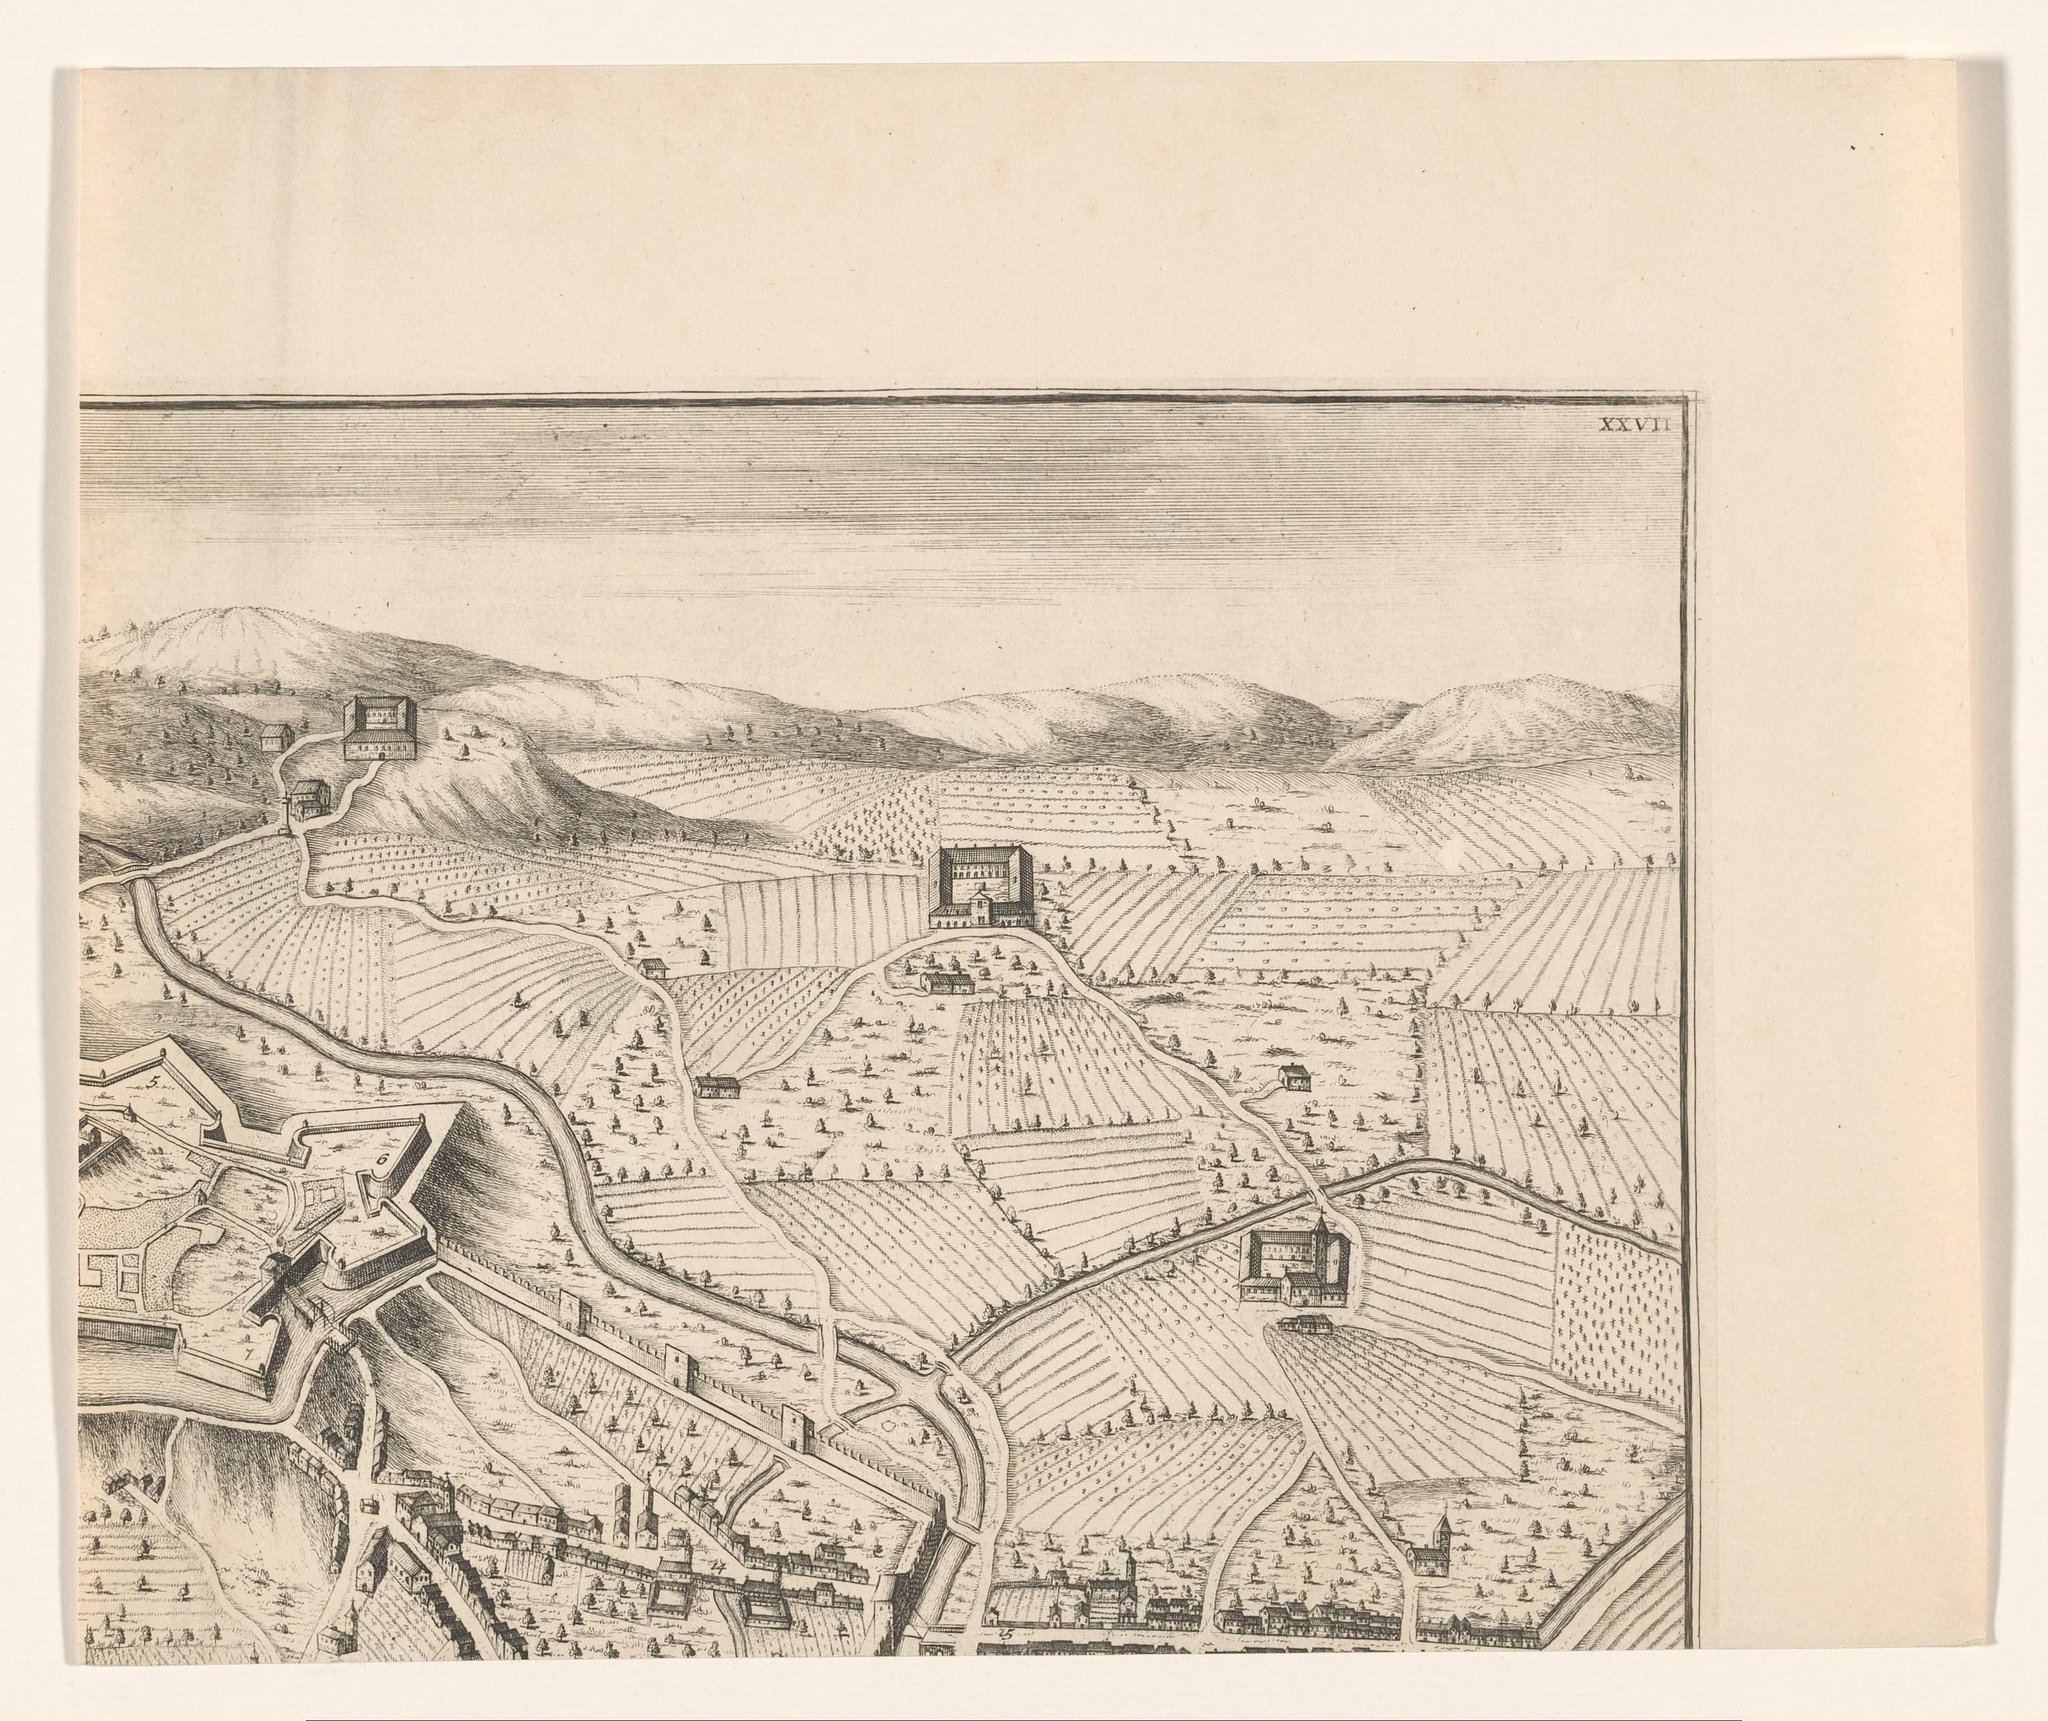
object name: area plan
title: Bergamo ville des Venitiens dans le Bergamasque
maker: Anonymous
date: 1704-1724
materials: paper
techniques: engraving, etching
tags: maps of cities, prospect of city, town panorama, silhouette of city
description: Plattegrond van Bergamo, gesneden in vier delen. Rechtsboven genummerd: XXVII.